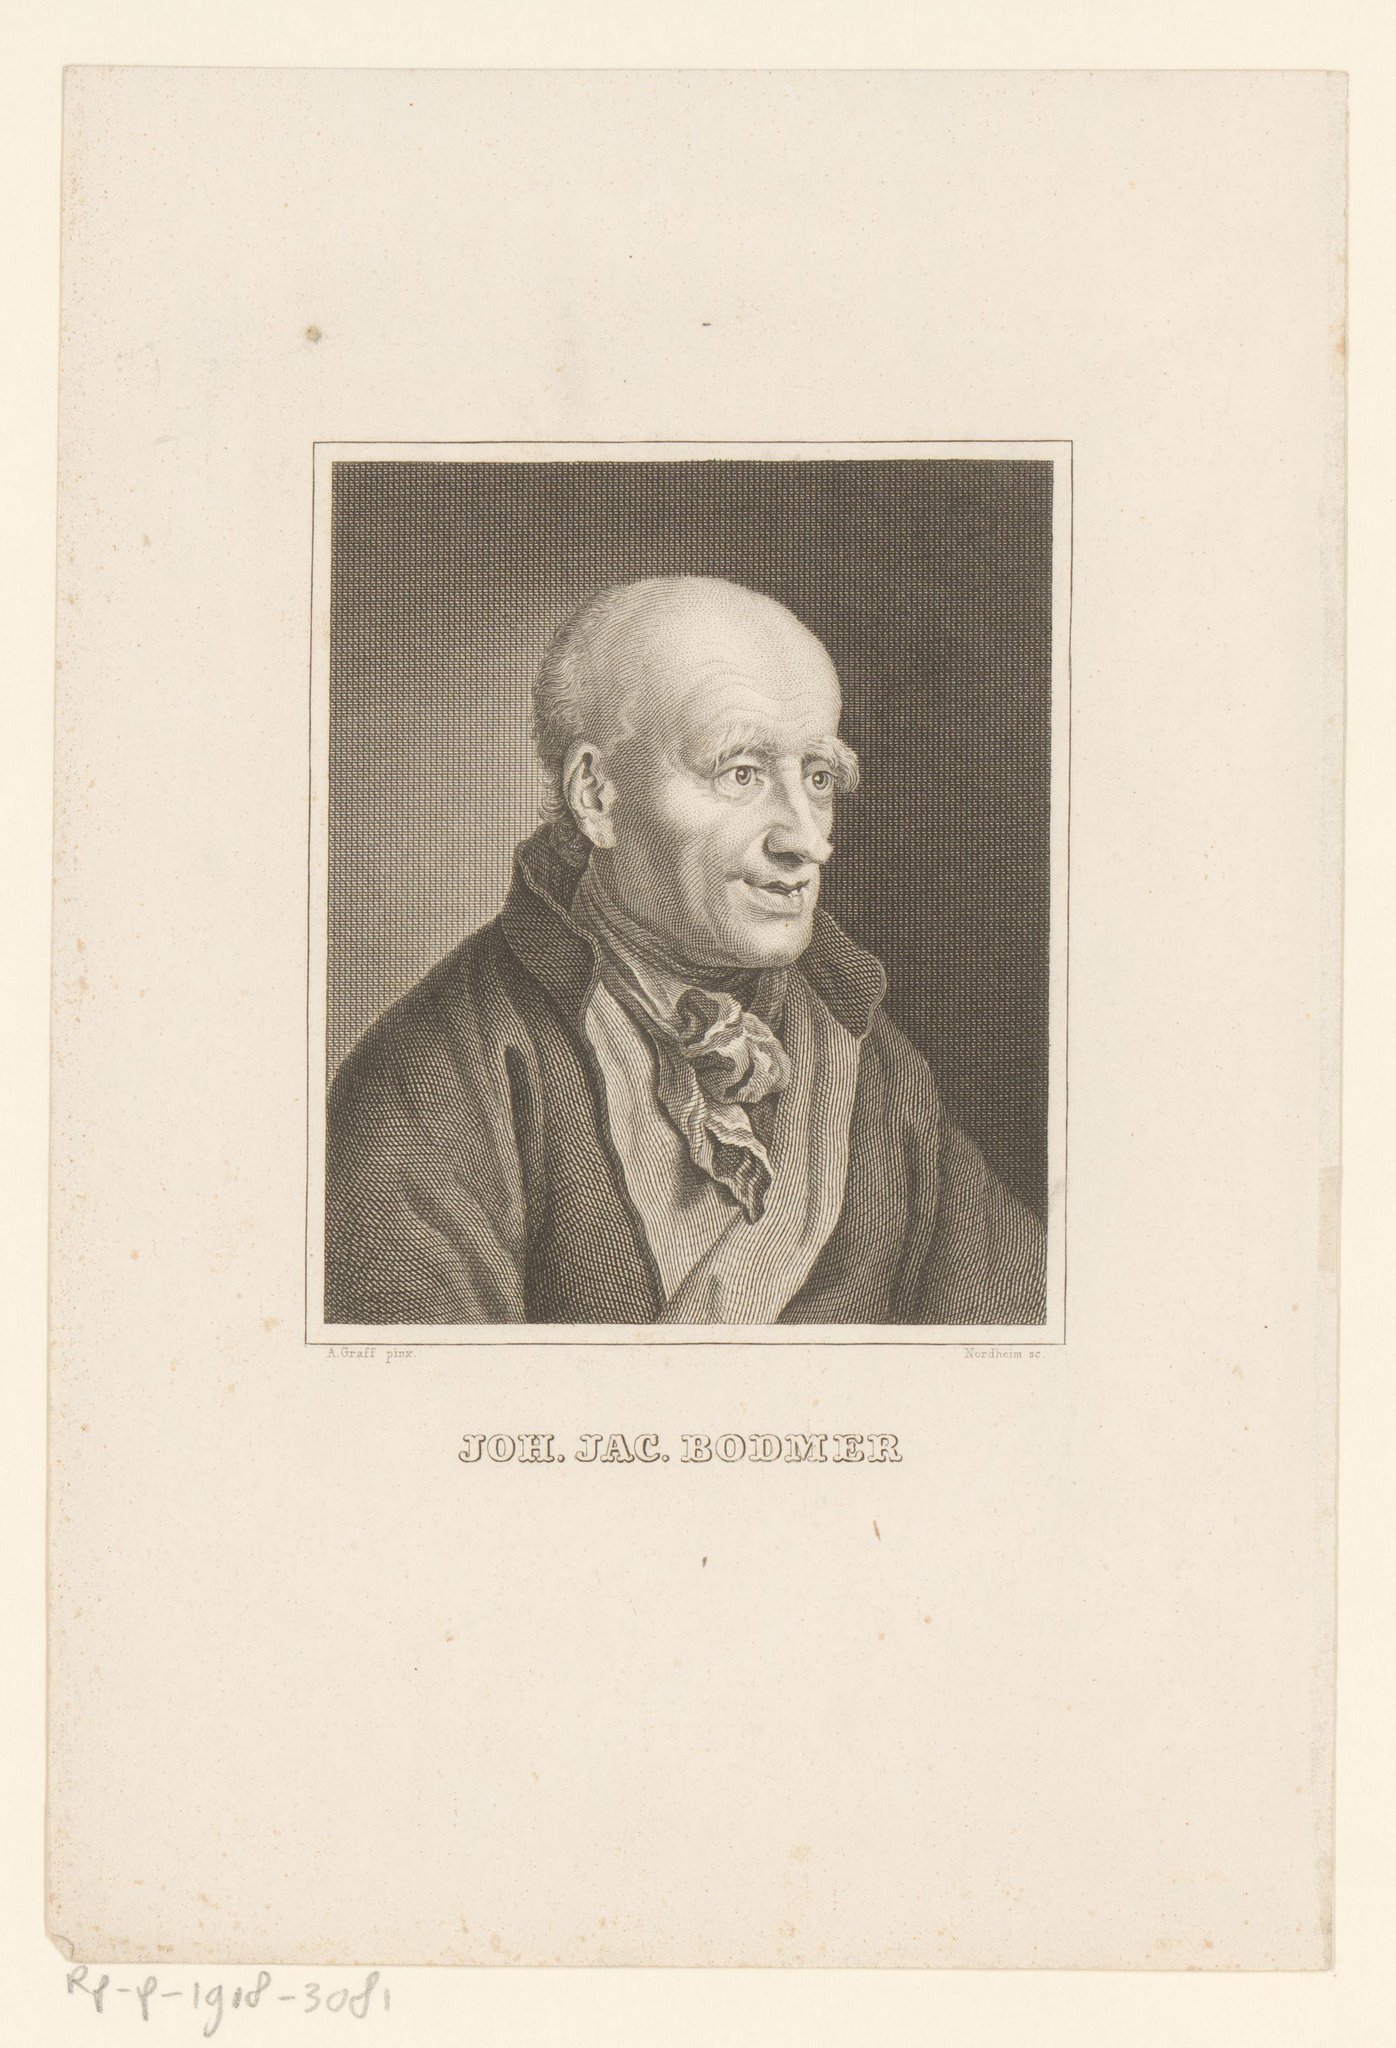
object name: print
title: Portret van Johann Jacob Bodmer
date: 1814-1829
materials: paper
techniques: engraving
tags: historical persons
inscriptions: collector's mark: Lugt 2228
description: Afkomstig uit de portretserie 'Zeitgenossen', uitgegeven tussen 1829 en circa 1840.